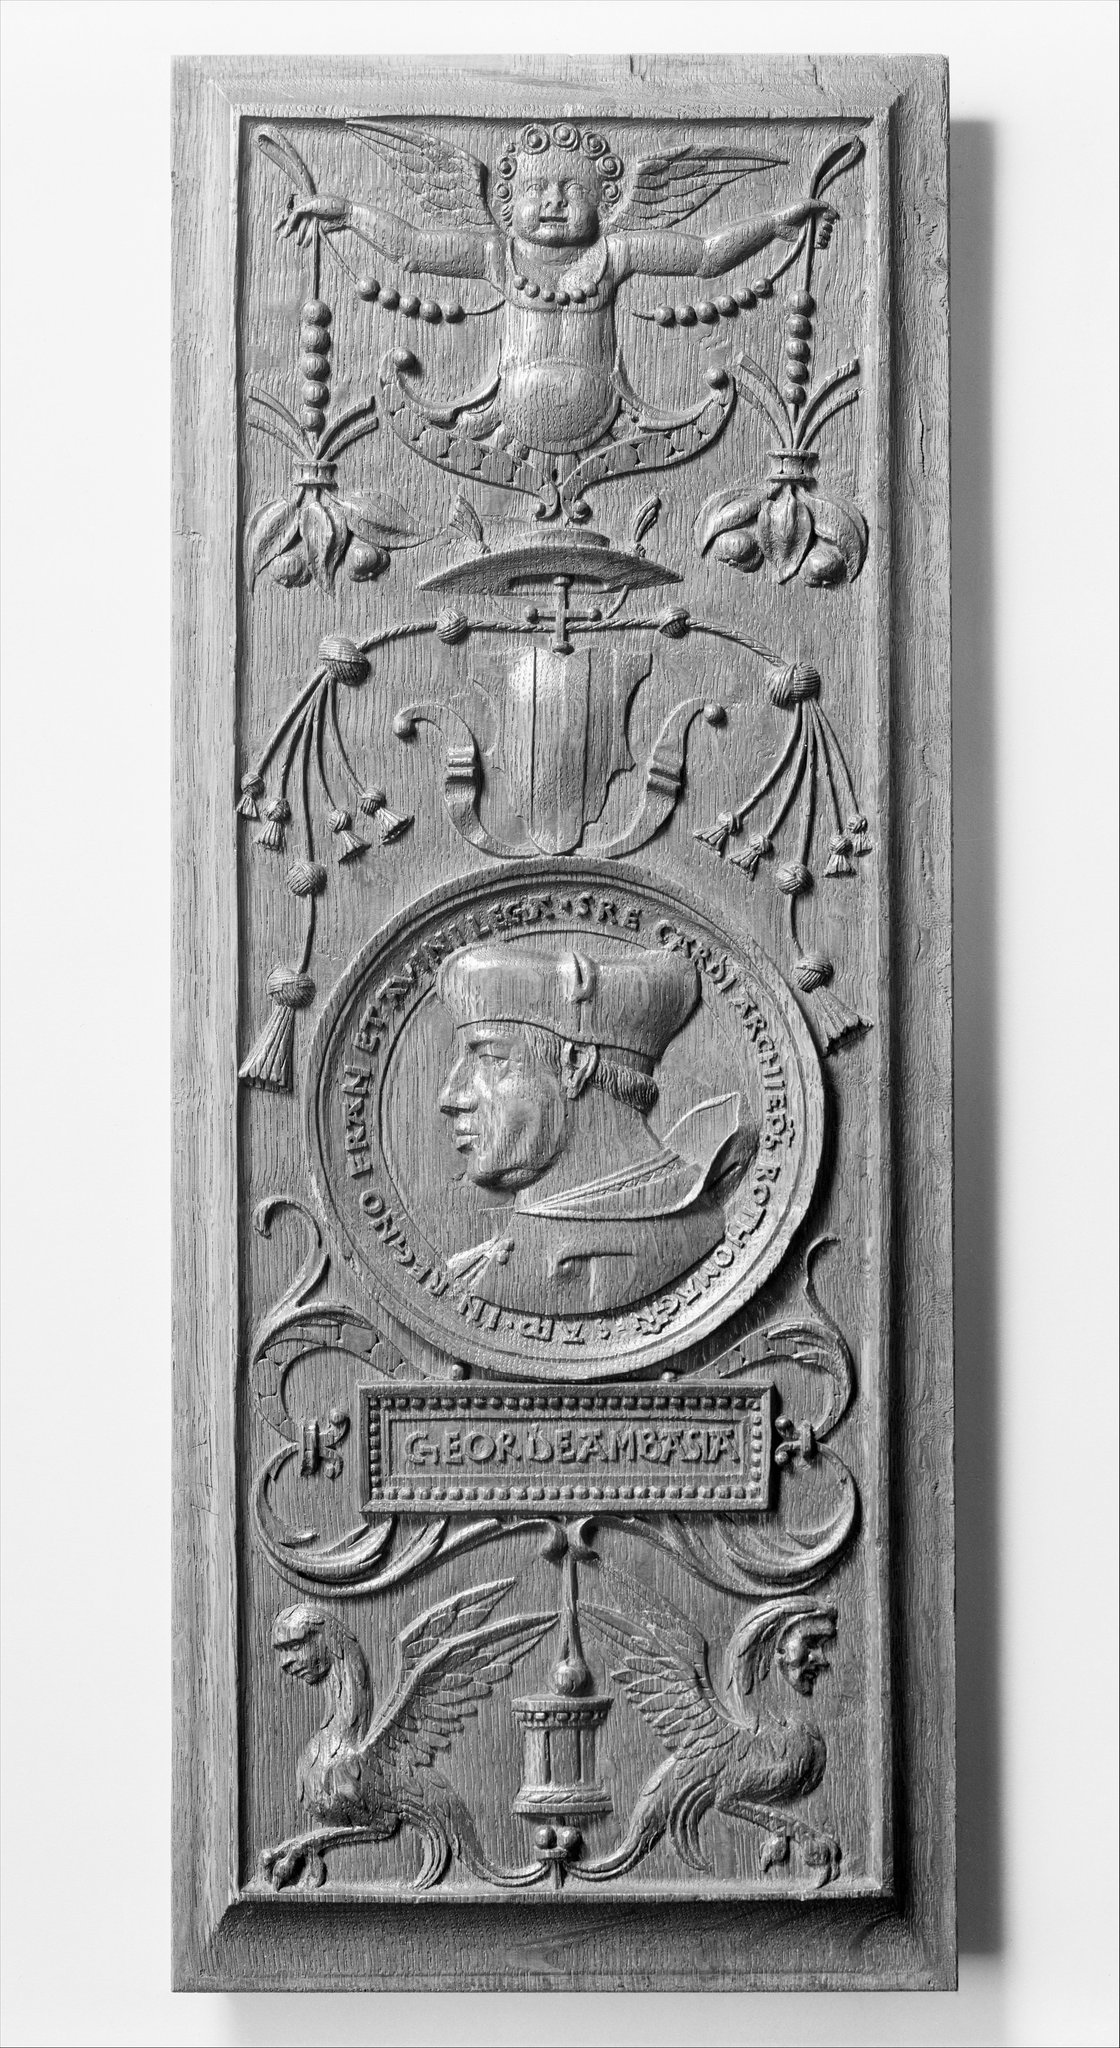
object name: panel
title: Panel (part of a set)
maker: nicolas castille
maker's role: maker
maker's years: 1503-1521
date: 1510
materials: wood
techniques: carving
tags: men,profiles